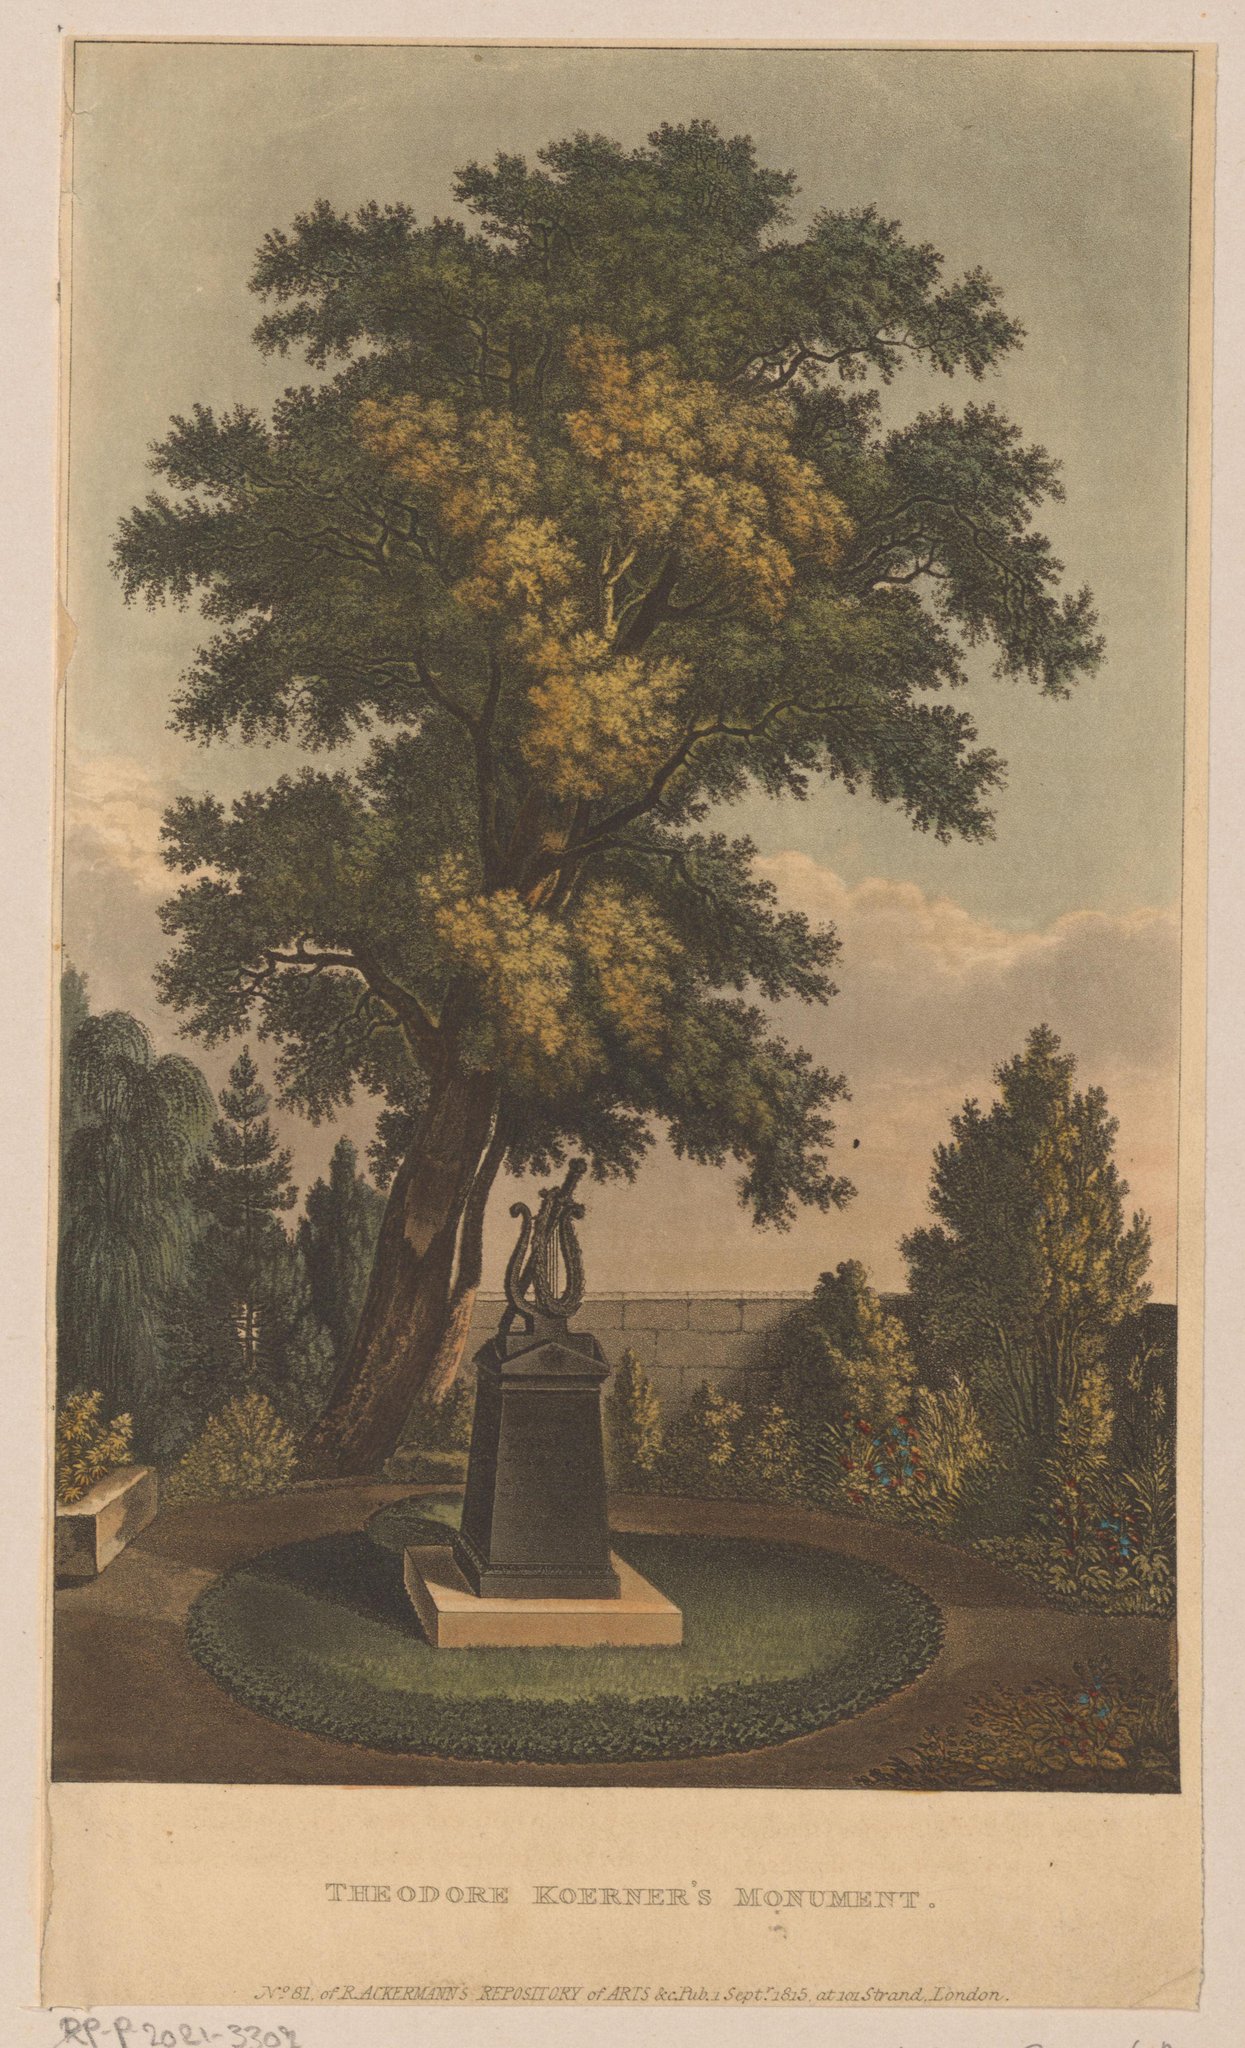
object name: print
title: Grafmonument voor Theodor Körner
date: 1815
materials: paper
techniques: aquatint, etching, hand coloring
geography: london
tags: grave, tomb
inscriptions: date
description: Prent uit: Ackermann's Repository of Arts, nr. 81, 1 september 1815.